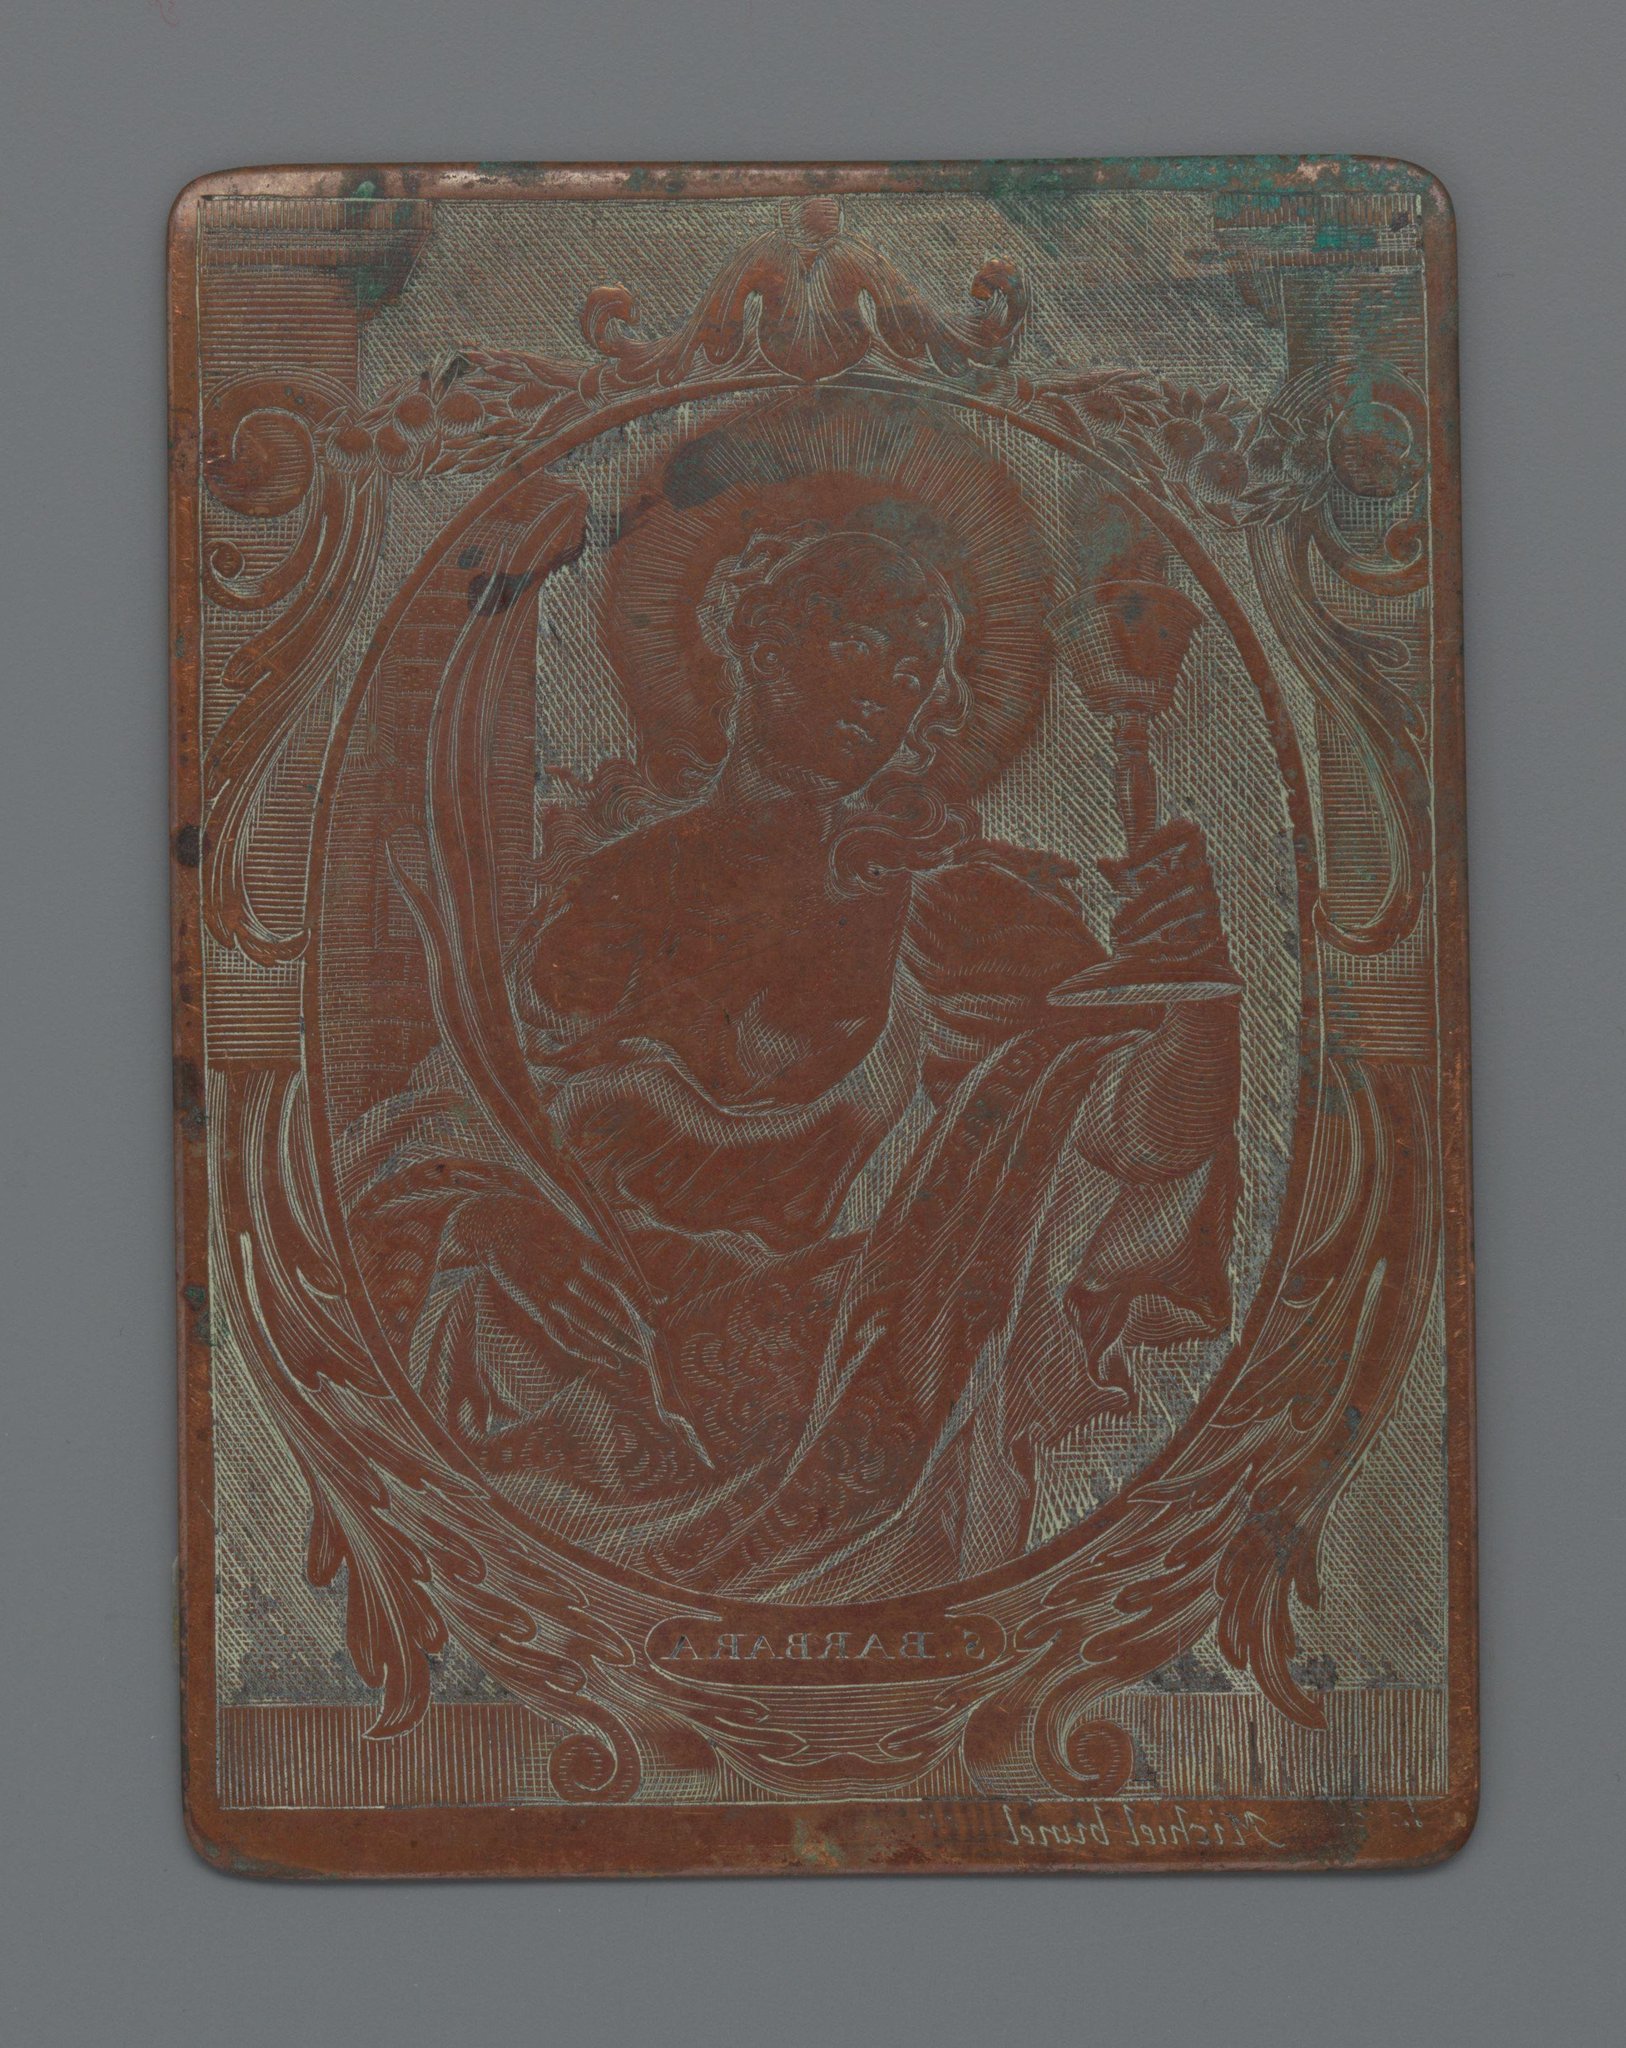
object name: copper plate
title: Koperplaat met de Heilige Barbara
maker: michel bunel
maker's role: print maker, publisher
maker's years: 1670-1739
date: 1680-1739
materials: copper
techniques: engraving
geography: antwerp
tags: the virgin martyr barbara; possible attributes: book, cannon(ball), crown, cross, chalice with wafer, dioscuros (her father), peacock feather, sword, torches, mason's tools, tower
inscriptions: signature: ‘Michiel Bunel’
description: De platen (RP-D-2014-9-1 t/m 35) zijn vrijwel allemaal vervaardigd door anonieme graveurs werkend voor de Antwerpse uitgevers Cornelis Galle, Frans Huberti (Huybrechts), Theodor van Merlen II en Michel Bunel. Vermoedelijk zijn ze uiteindelijk beland in één fonds, wellicht dat van Michel Bunel (1670-1739) en warden sindsdien bij elkaar bewaard. Afwijkend is de grote prent van Henry Verbruggen met een weergave van de Preekstoel uit de St. Gudule-kerk te Brussel. Twee prenten zijn verpakt in een oude afdruk van de prent, zoals te doen gebruikelijk in uitgeverijen (vergl. oude platen in Museum Plantijn Moretus, Antwerpen). Van 8 platen heeft de vorige eigenaar afdrukken laten maken op modern papier.